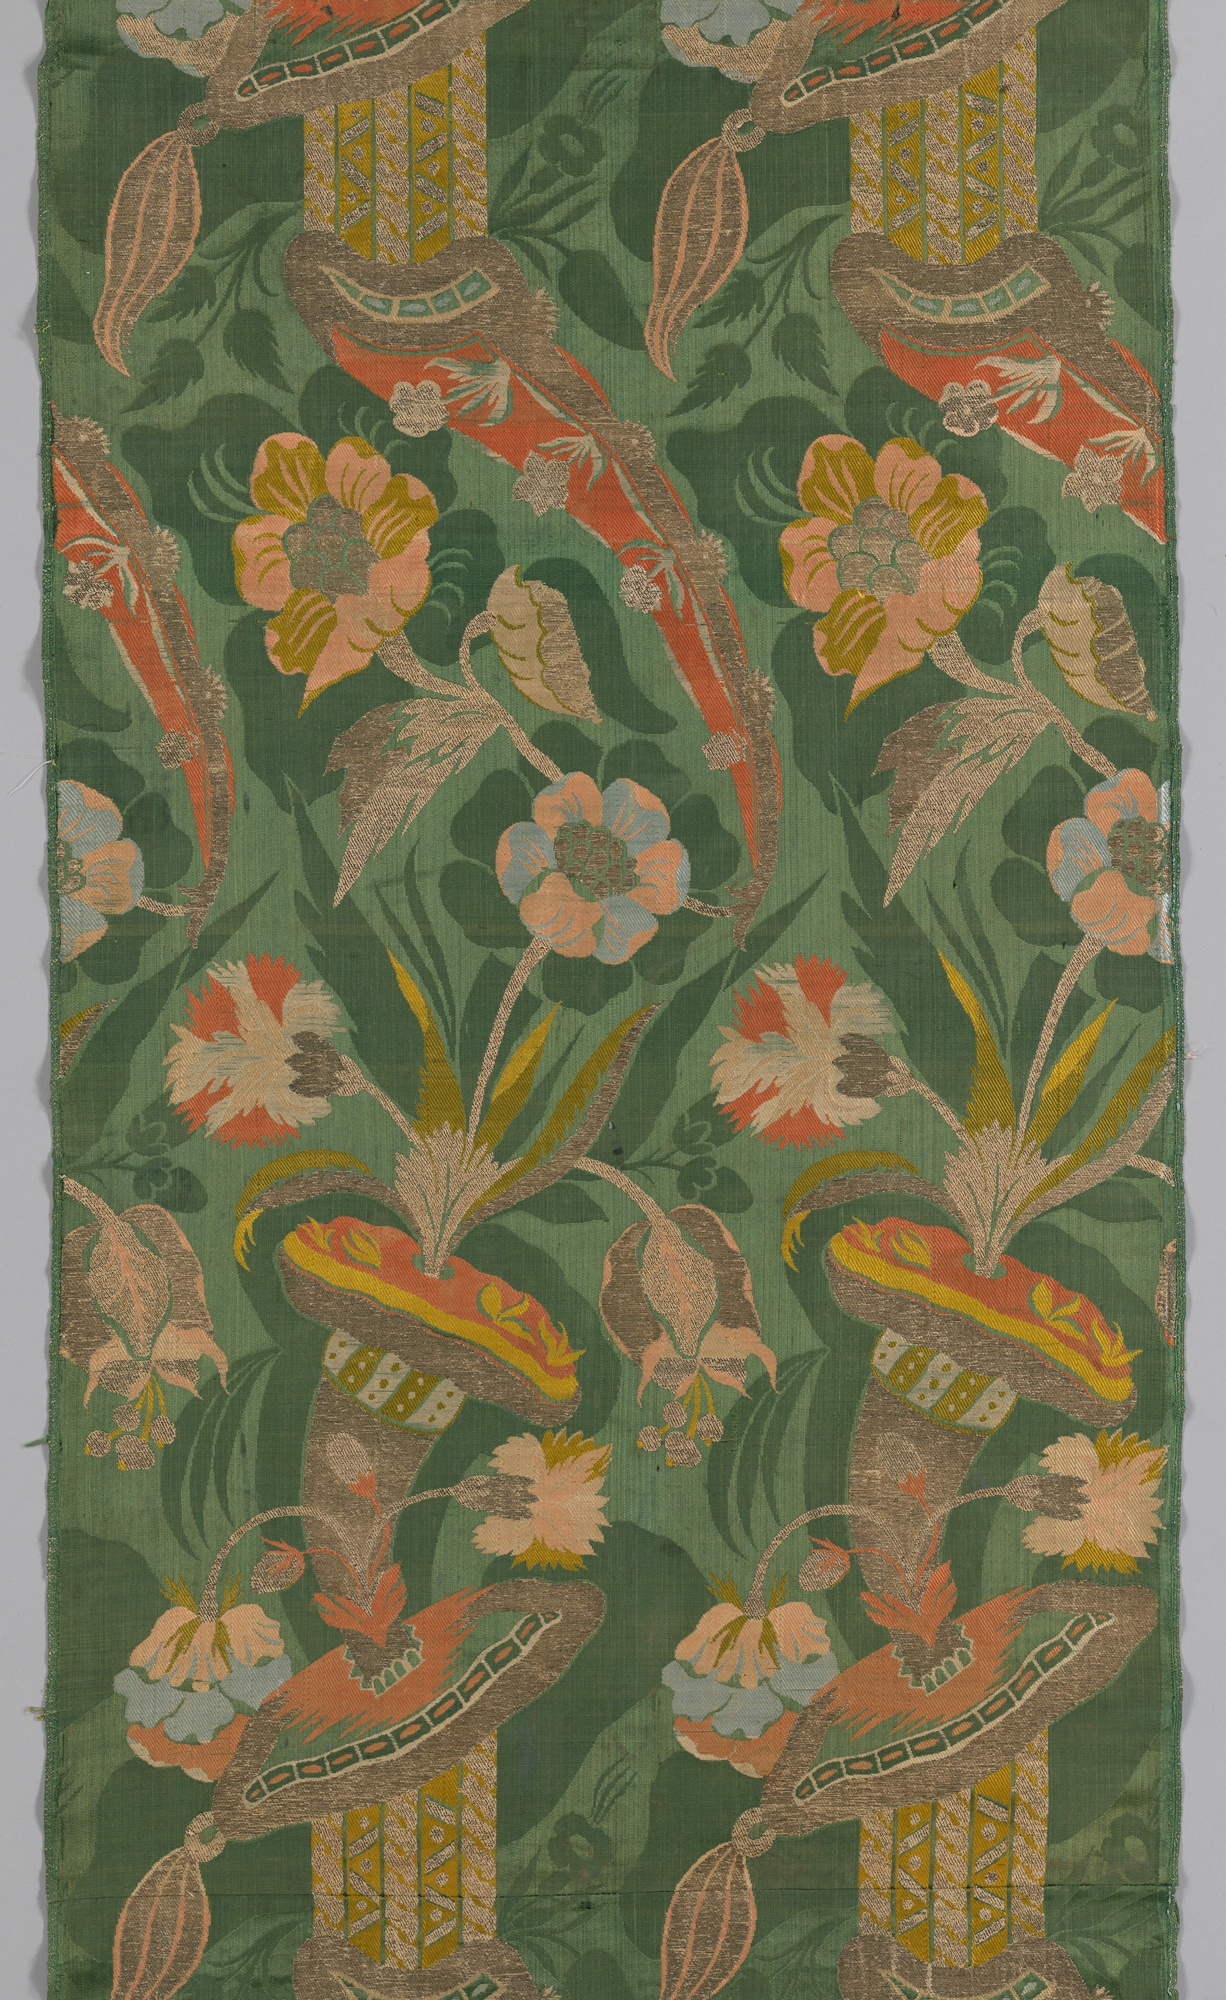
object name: piece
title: Pieces (3)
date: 1701-1733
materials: metal thread, silk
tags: flowers,leaves